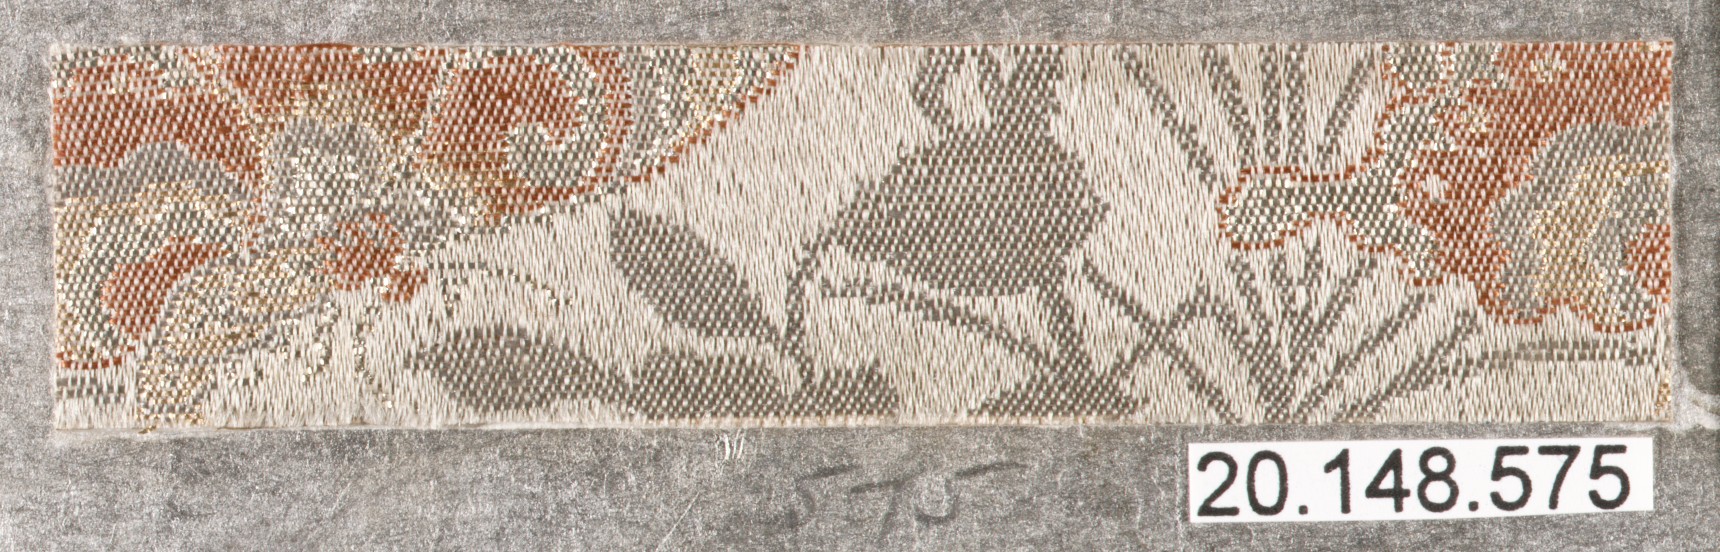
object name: piece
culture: japanese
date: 1701-1800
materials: silk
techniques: compound weave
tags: leaves